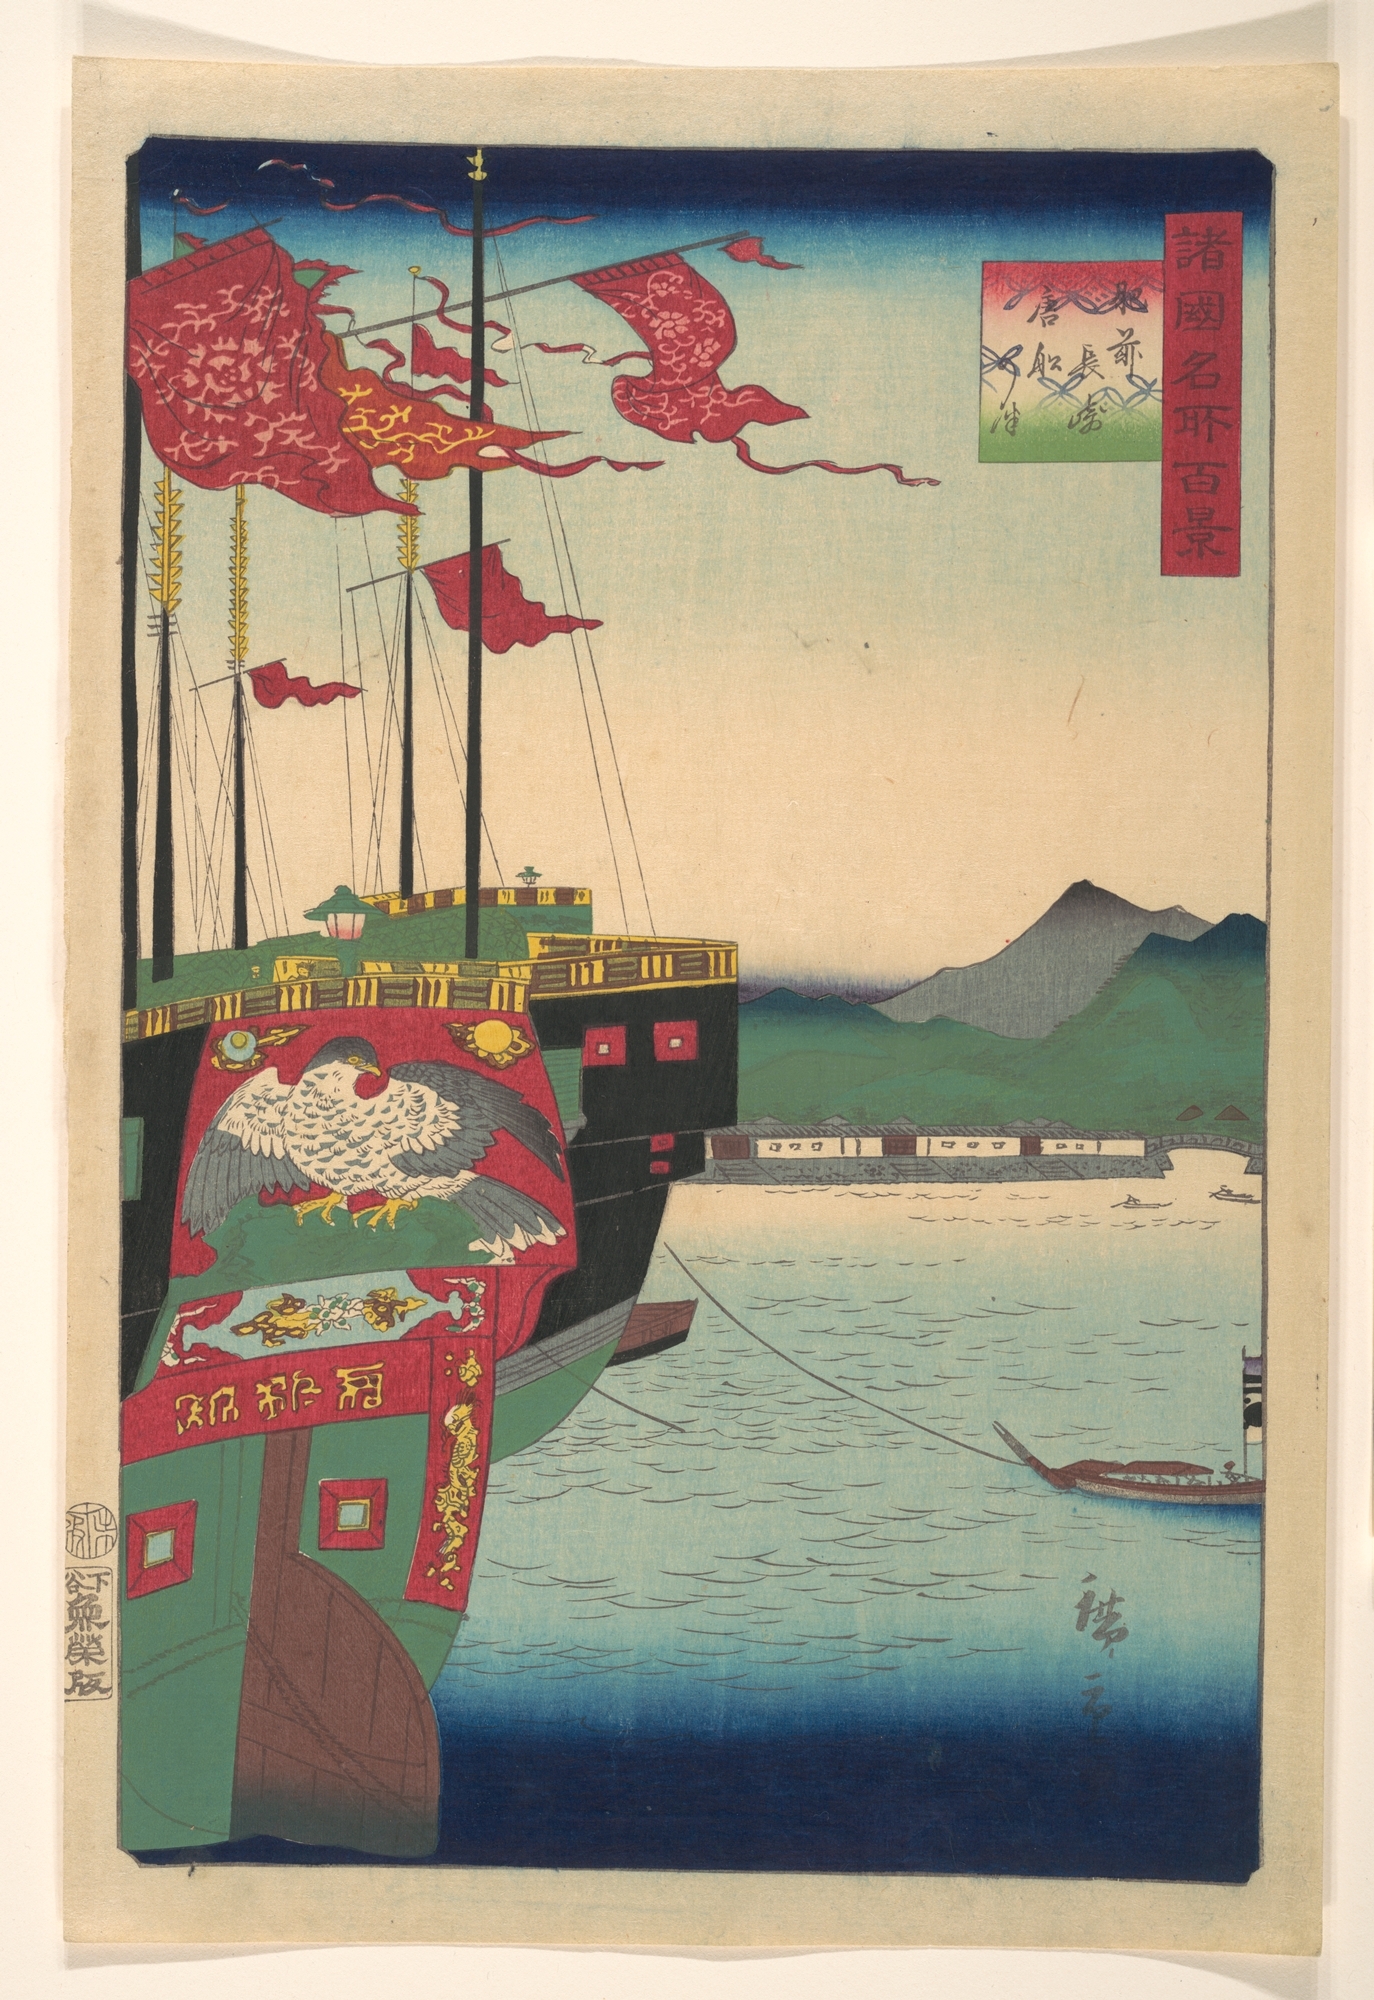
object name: print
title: Dutch and Chinese Ships in the Harbor at Nagasaki in Hizen Province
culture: japanese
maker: utagawa hiroshige ii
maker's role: artist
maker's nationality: japanese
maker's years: 1826-1869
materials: ink, paper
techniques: woodblock print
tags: eagles,flags,ships